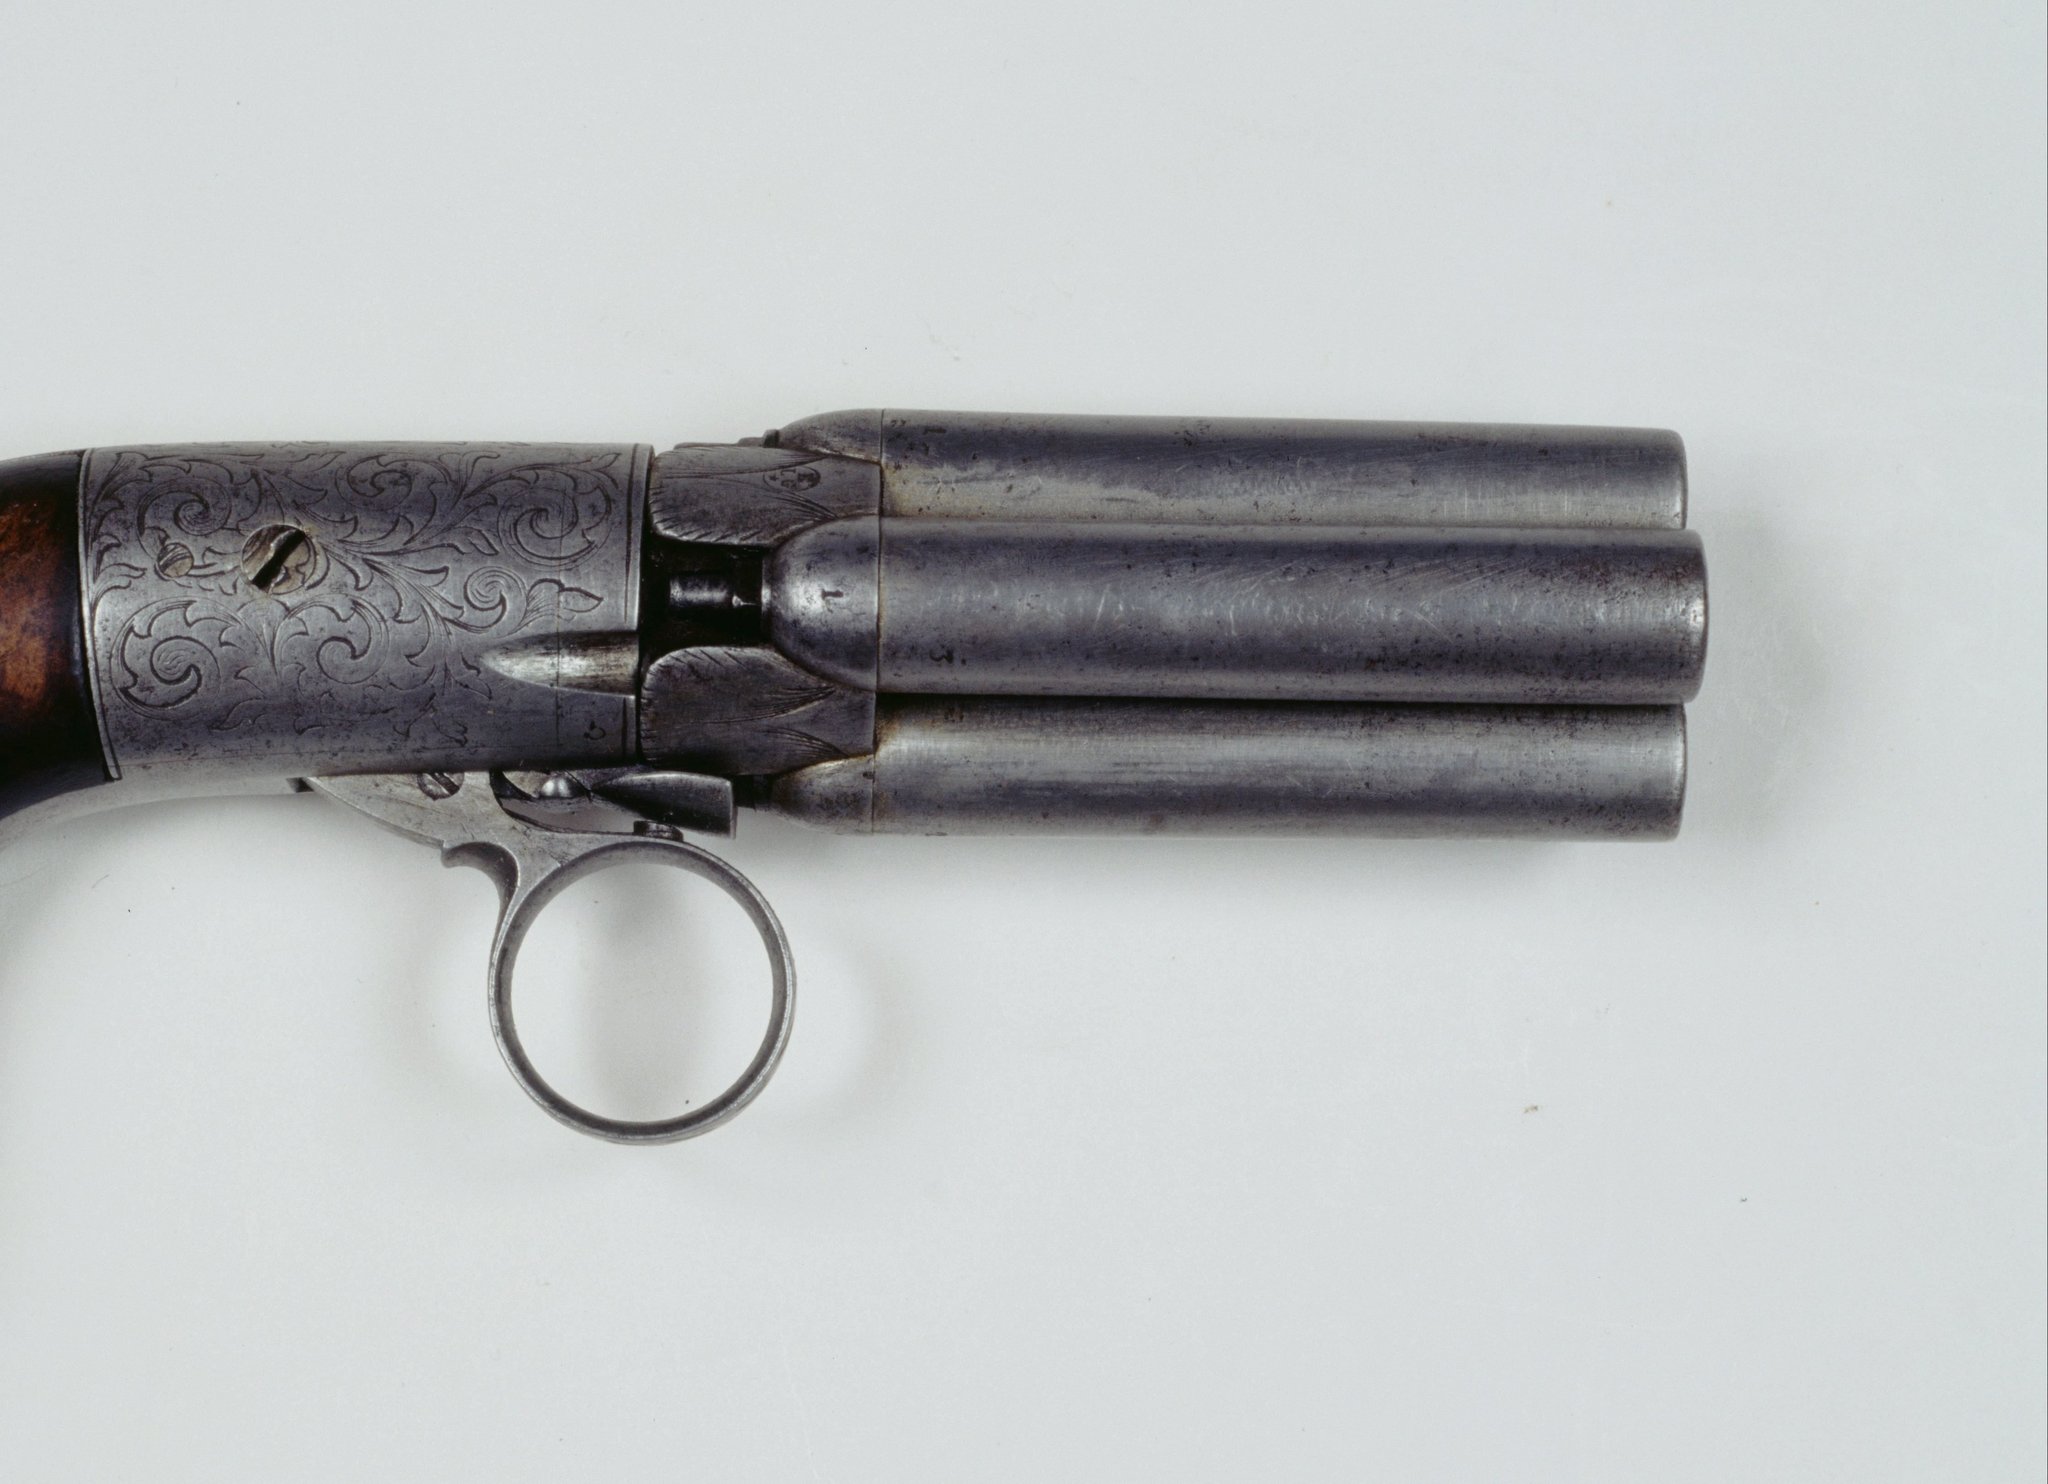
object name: pistol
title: Vierloops zakpistool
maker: guillaume mariëtte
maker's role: geweermaker, pistoolmaker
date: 1799-1893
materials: iron, wood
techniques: engraving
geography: cheratte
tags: netherlands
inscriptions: mark: ‘LEG’, mark: ‘1 // 2 // 3 // 4’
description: Vierloops zakpistool, zogenaamde peperbus, deel van een koppel. Vier lopen, rond en glad, gemerkt 1 t/m 4. Op het draaibare gedeelte gemerkt: 'LEG' in ovaal. Gegraveerde slotkast. Ringvormige trekker. Geen draagring.